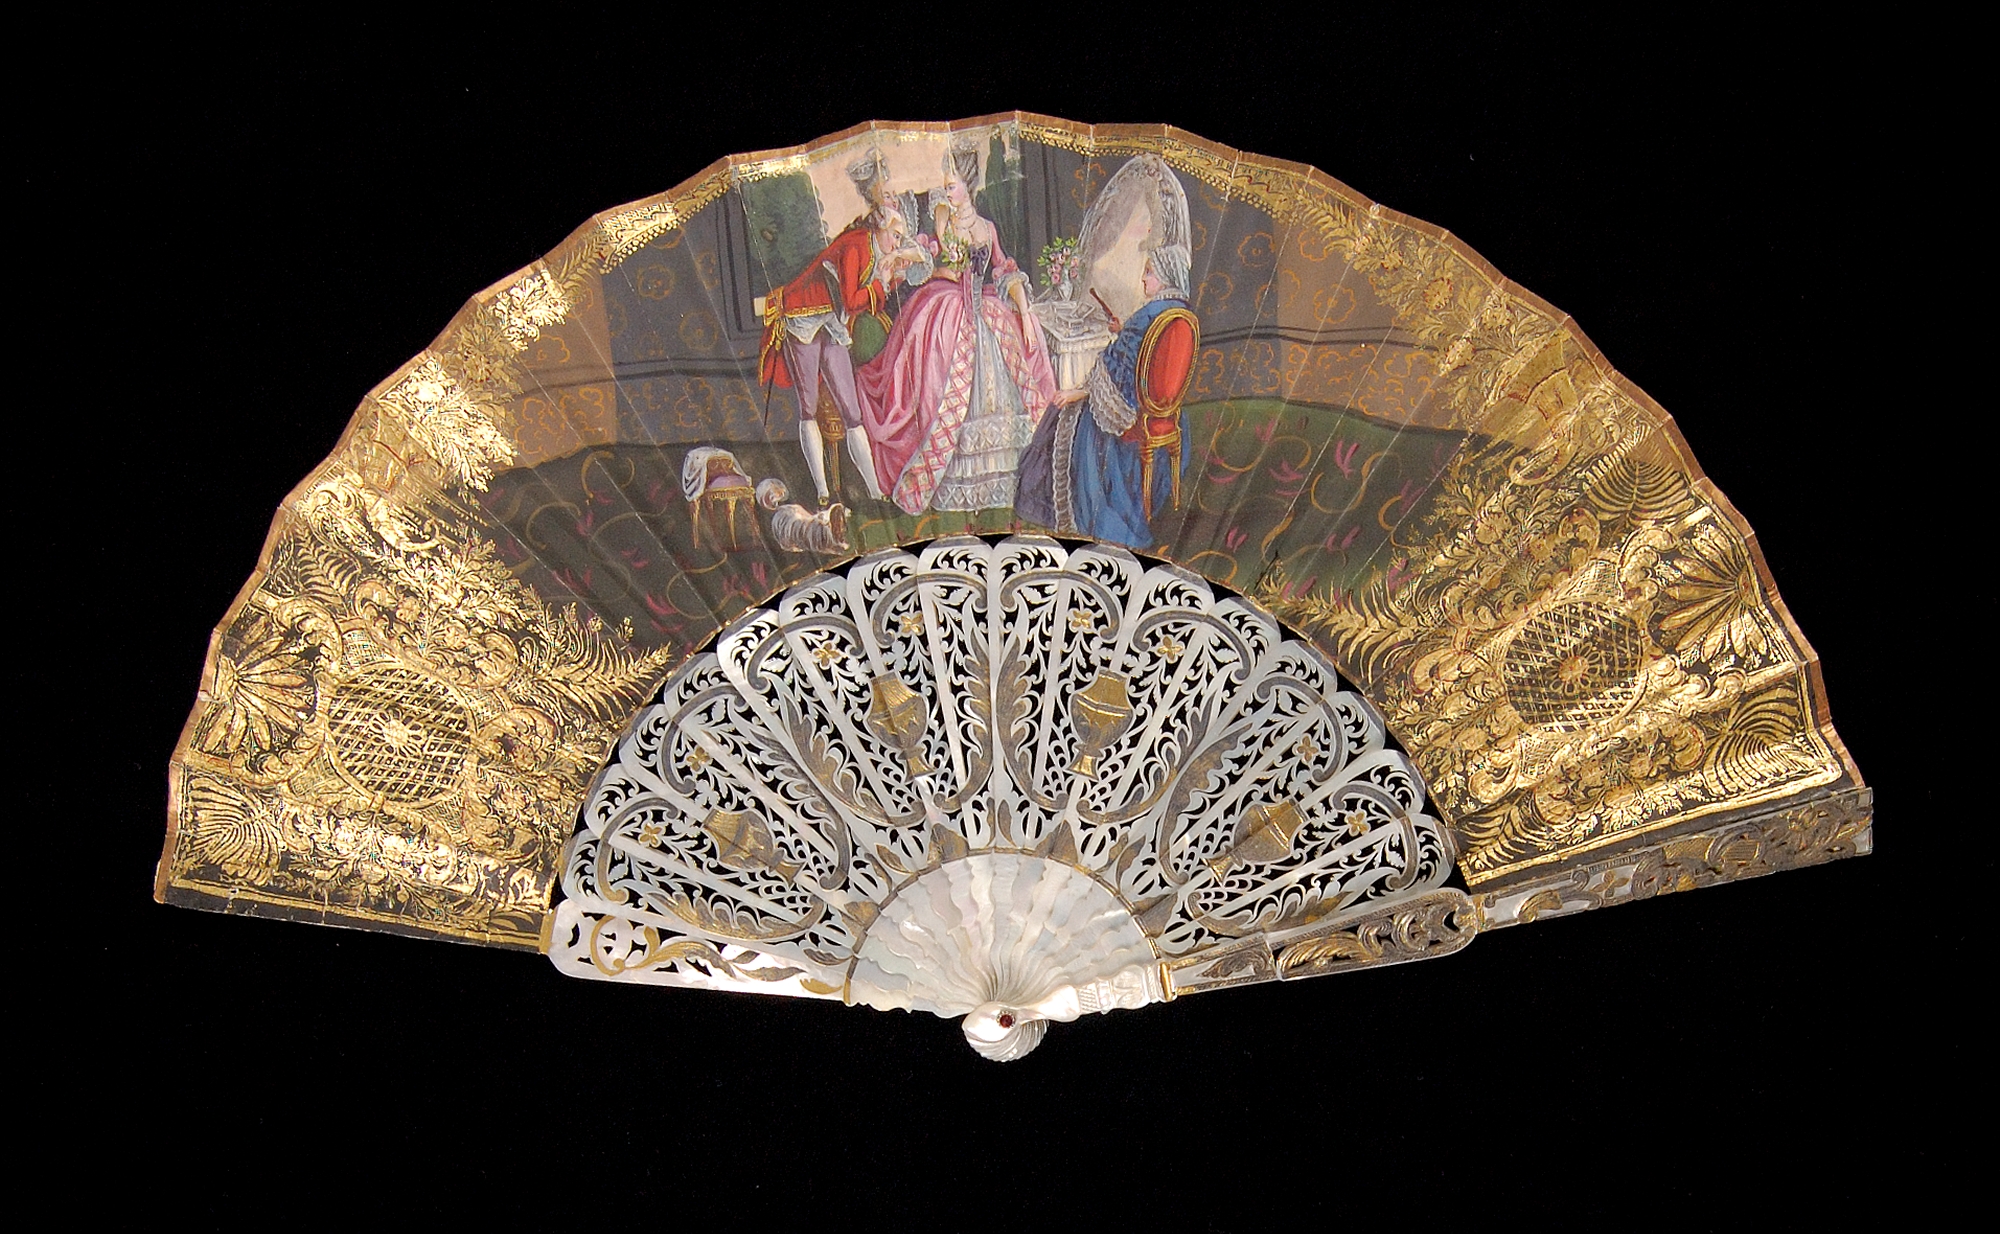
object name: fan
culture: european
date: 1855-1865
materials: mother of pearl, paper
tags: men,women,dogs